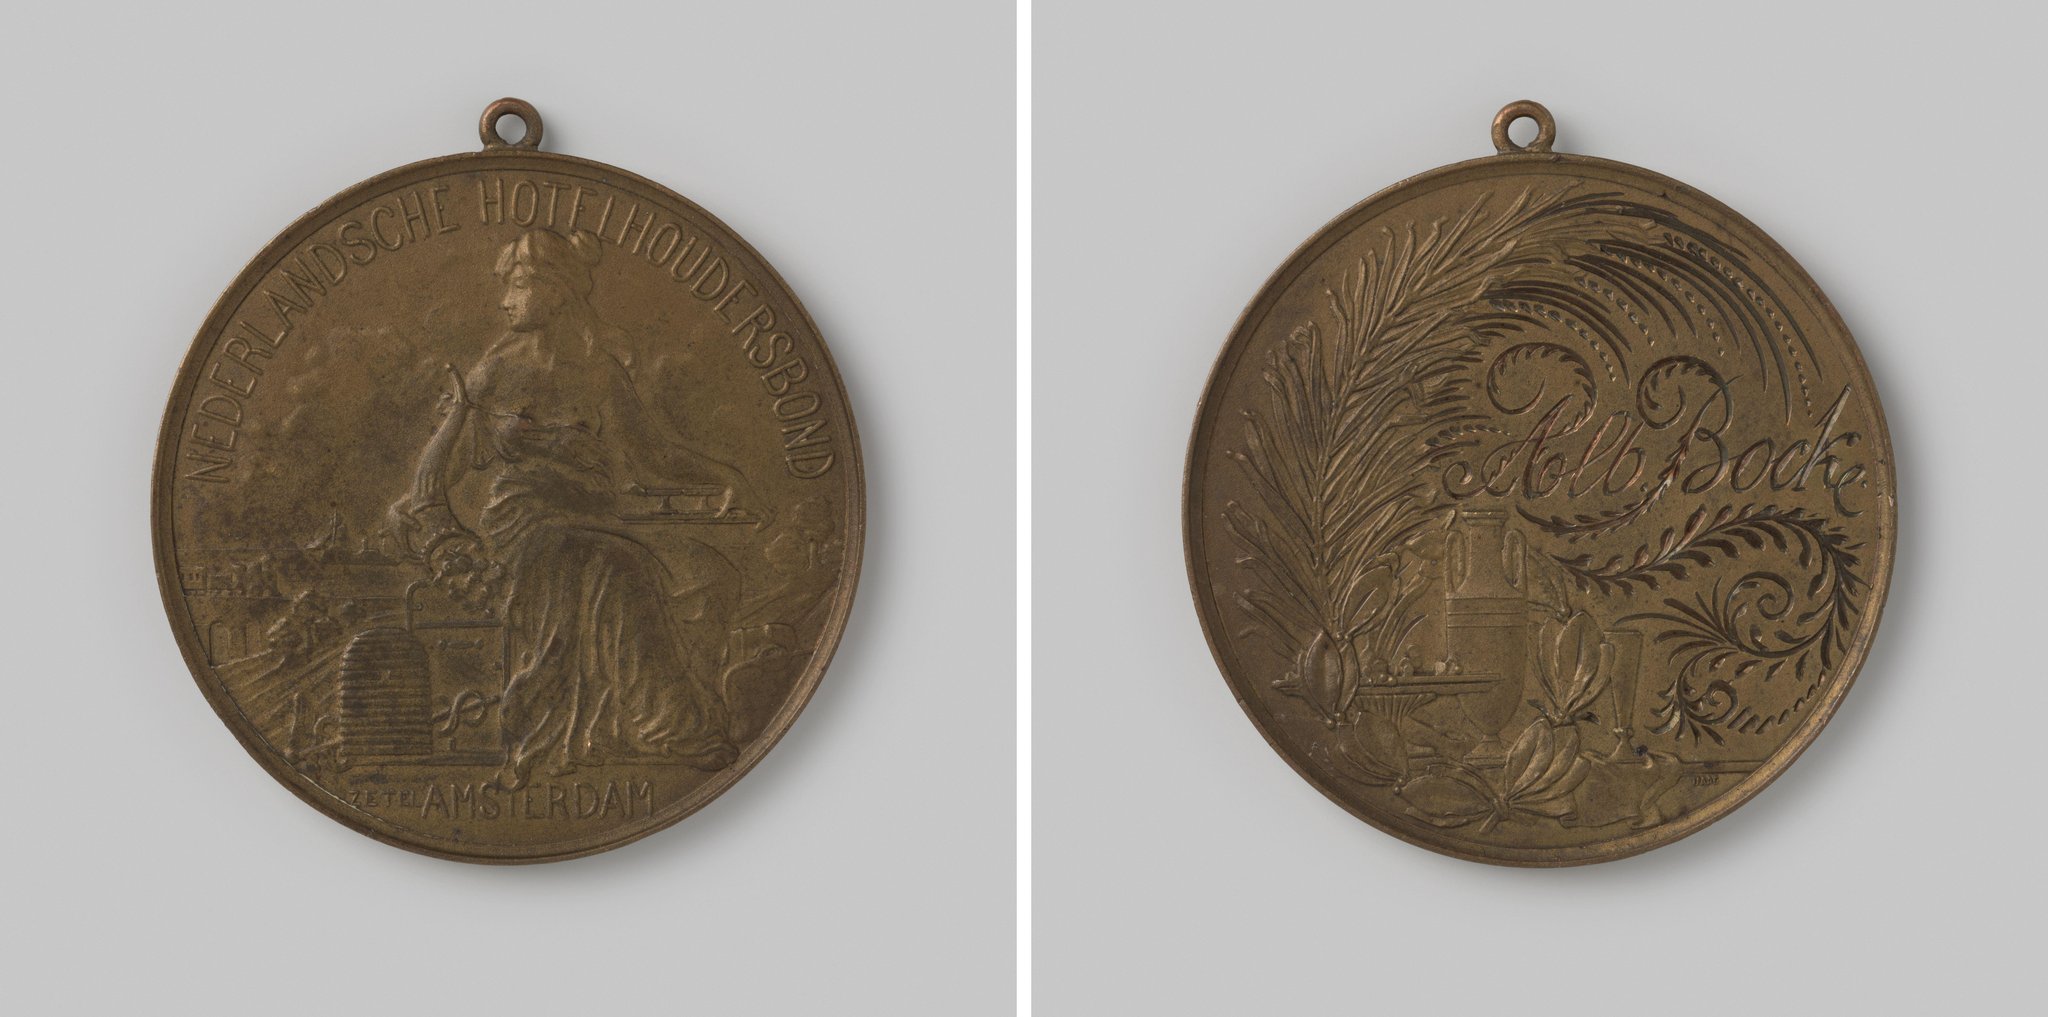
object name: history medal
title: Prijspenning van de Nederlandsche Hotelhoudersbond te Amsterdam (1900) op naam van Alb. Bocke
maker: j.a.a. gerritsen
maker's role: manufacturer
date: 1900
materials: brass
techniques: striking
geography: zeist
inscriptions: inscription: ‘Alb. Bock’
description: Messing penning met draagoog, op de voorzijde een zittende vrouw met hoorn des overvloeds te midden van symbolen van nijverheid, handel en transport, met omschrift en afsnedetekst, op de keerzijde een inscriptieveld, met links vaatwerk, lauwer- en palmtakken, gegraveerd met meer loofwerk en een naam.